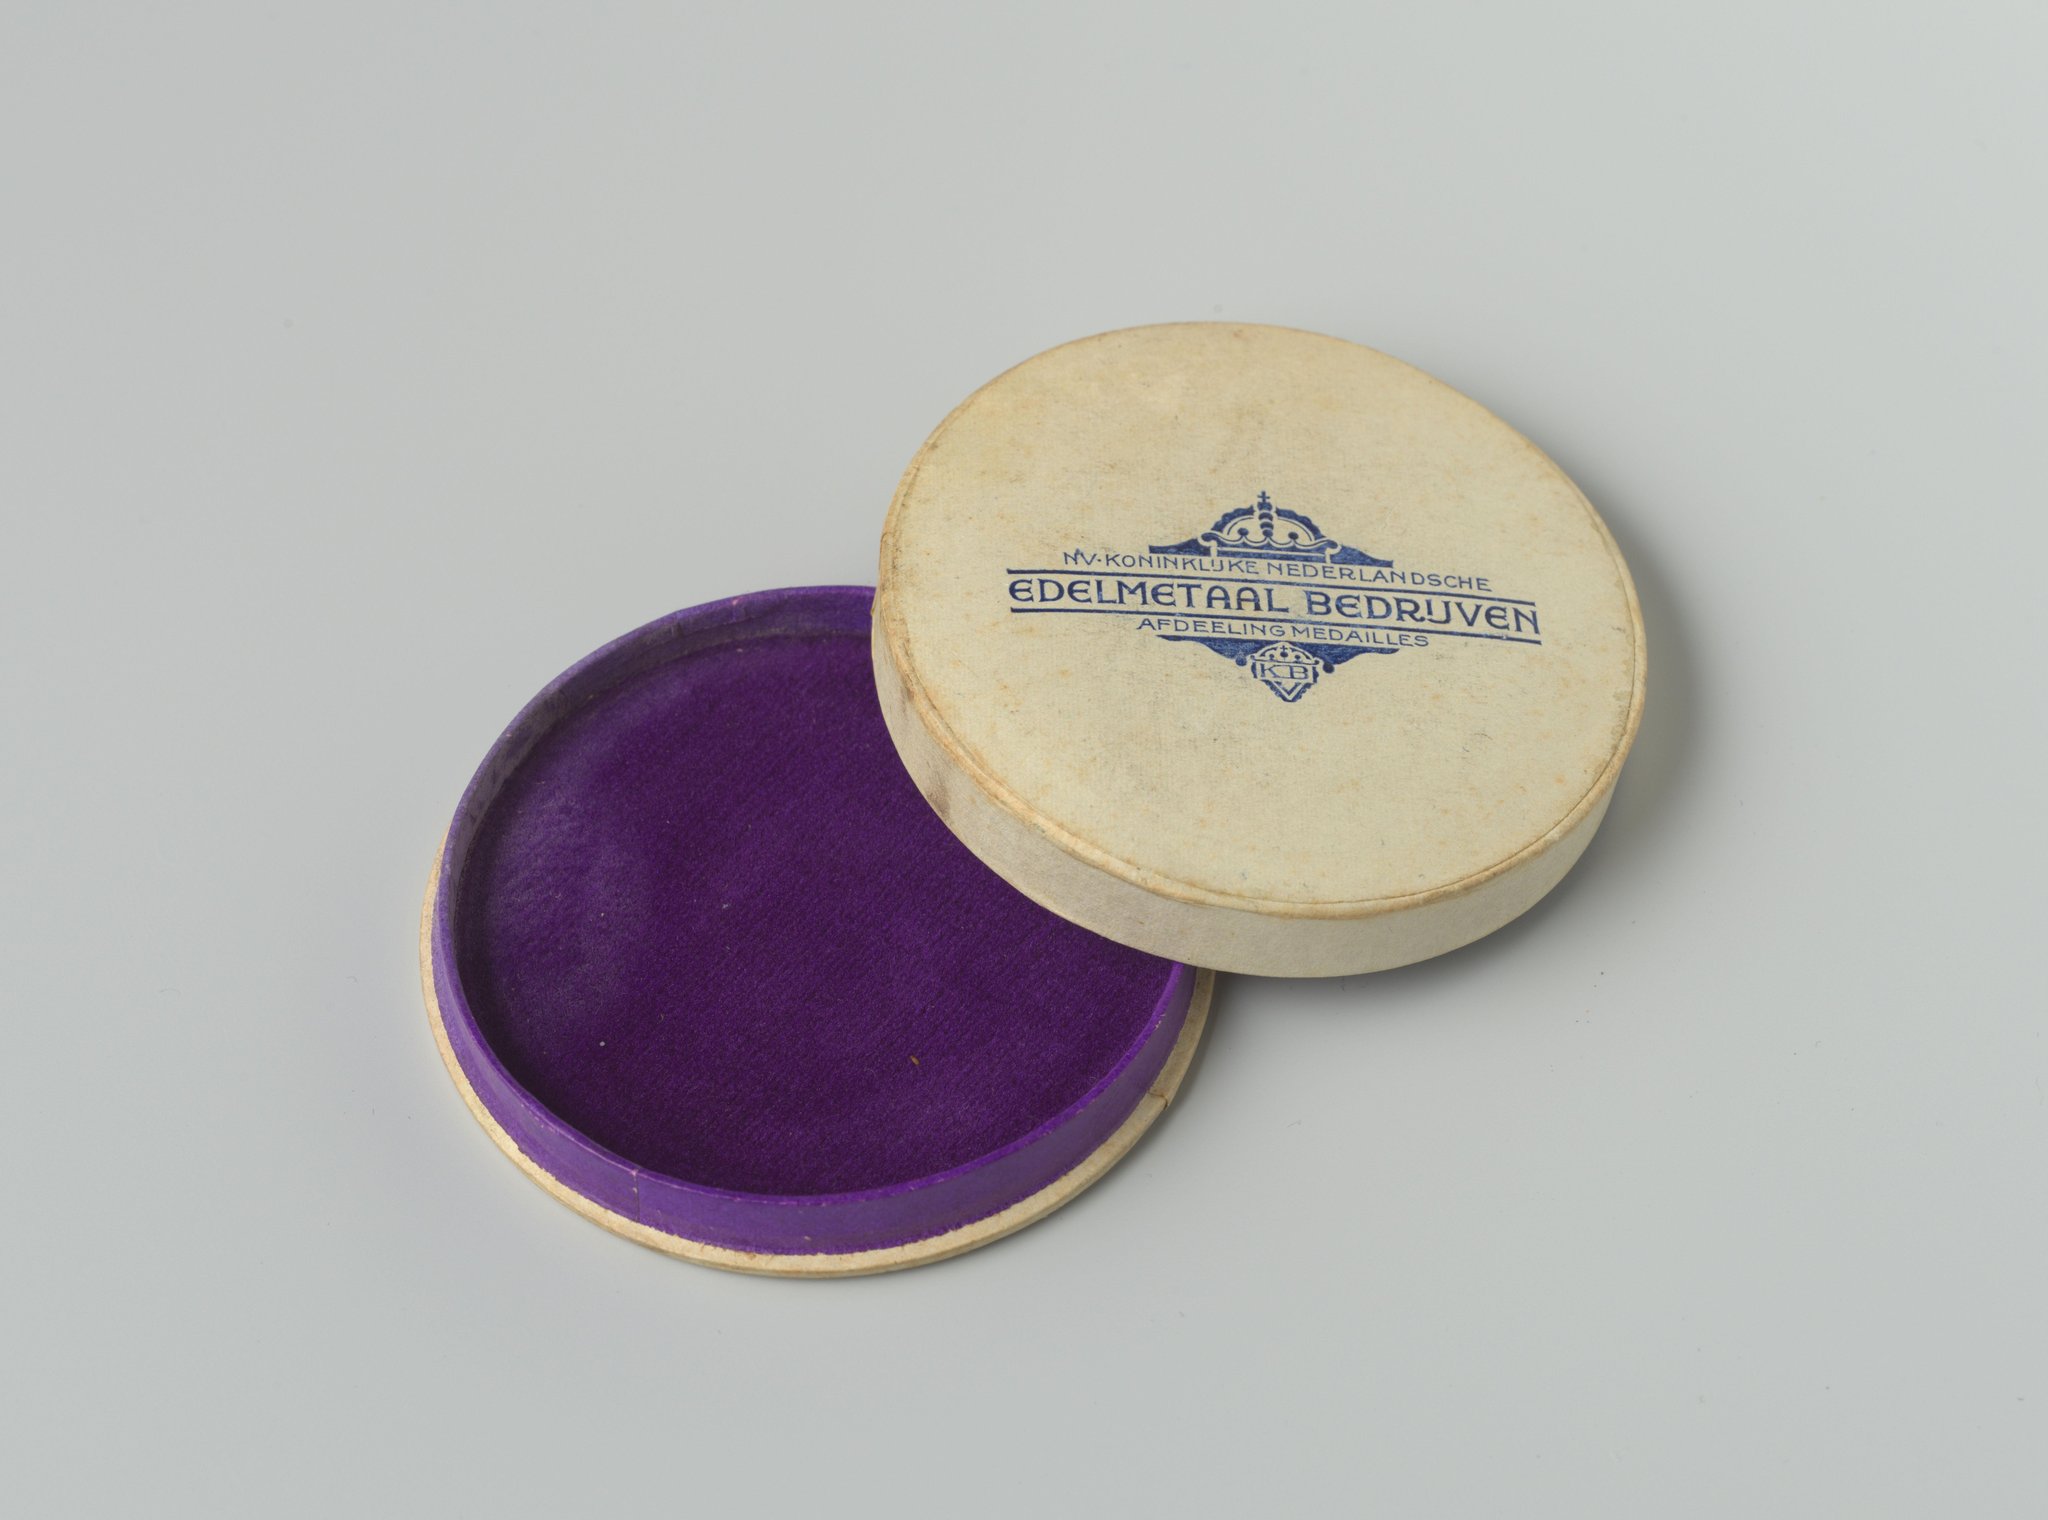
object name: medal box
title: Medal box for the medal on the jubilee exhibition for the silver anniversary of the reign of Queen Wilhelmina, in name of Nicolaas Swellengrebel.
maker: johannes cornelis wienecke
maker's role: medailleur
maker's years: 1872-1945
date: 1923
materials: cardboard, velvet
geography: utrecht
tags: the hague, print maker, wilhelmina of the netherlands, amsterdam, nicolaas hendrik swellengrebel